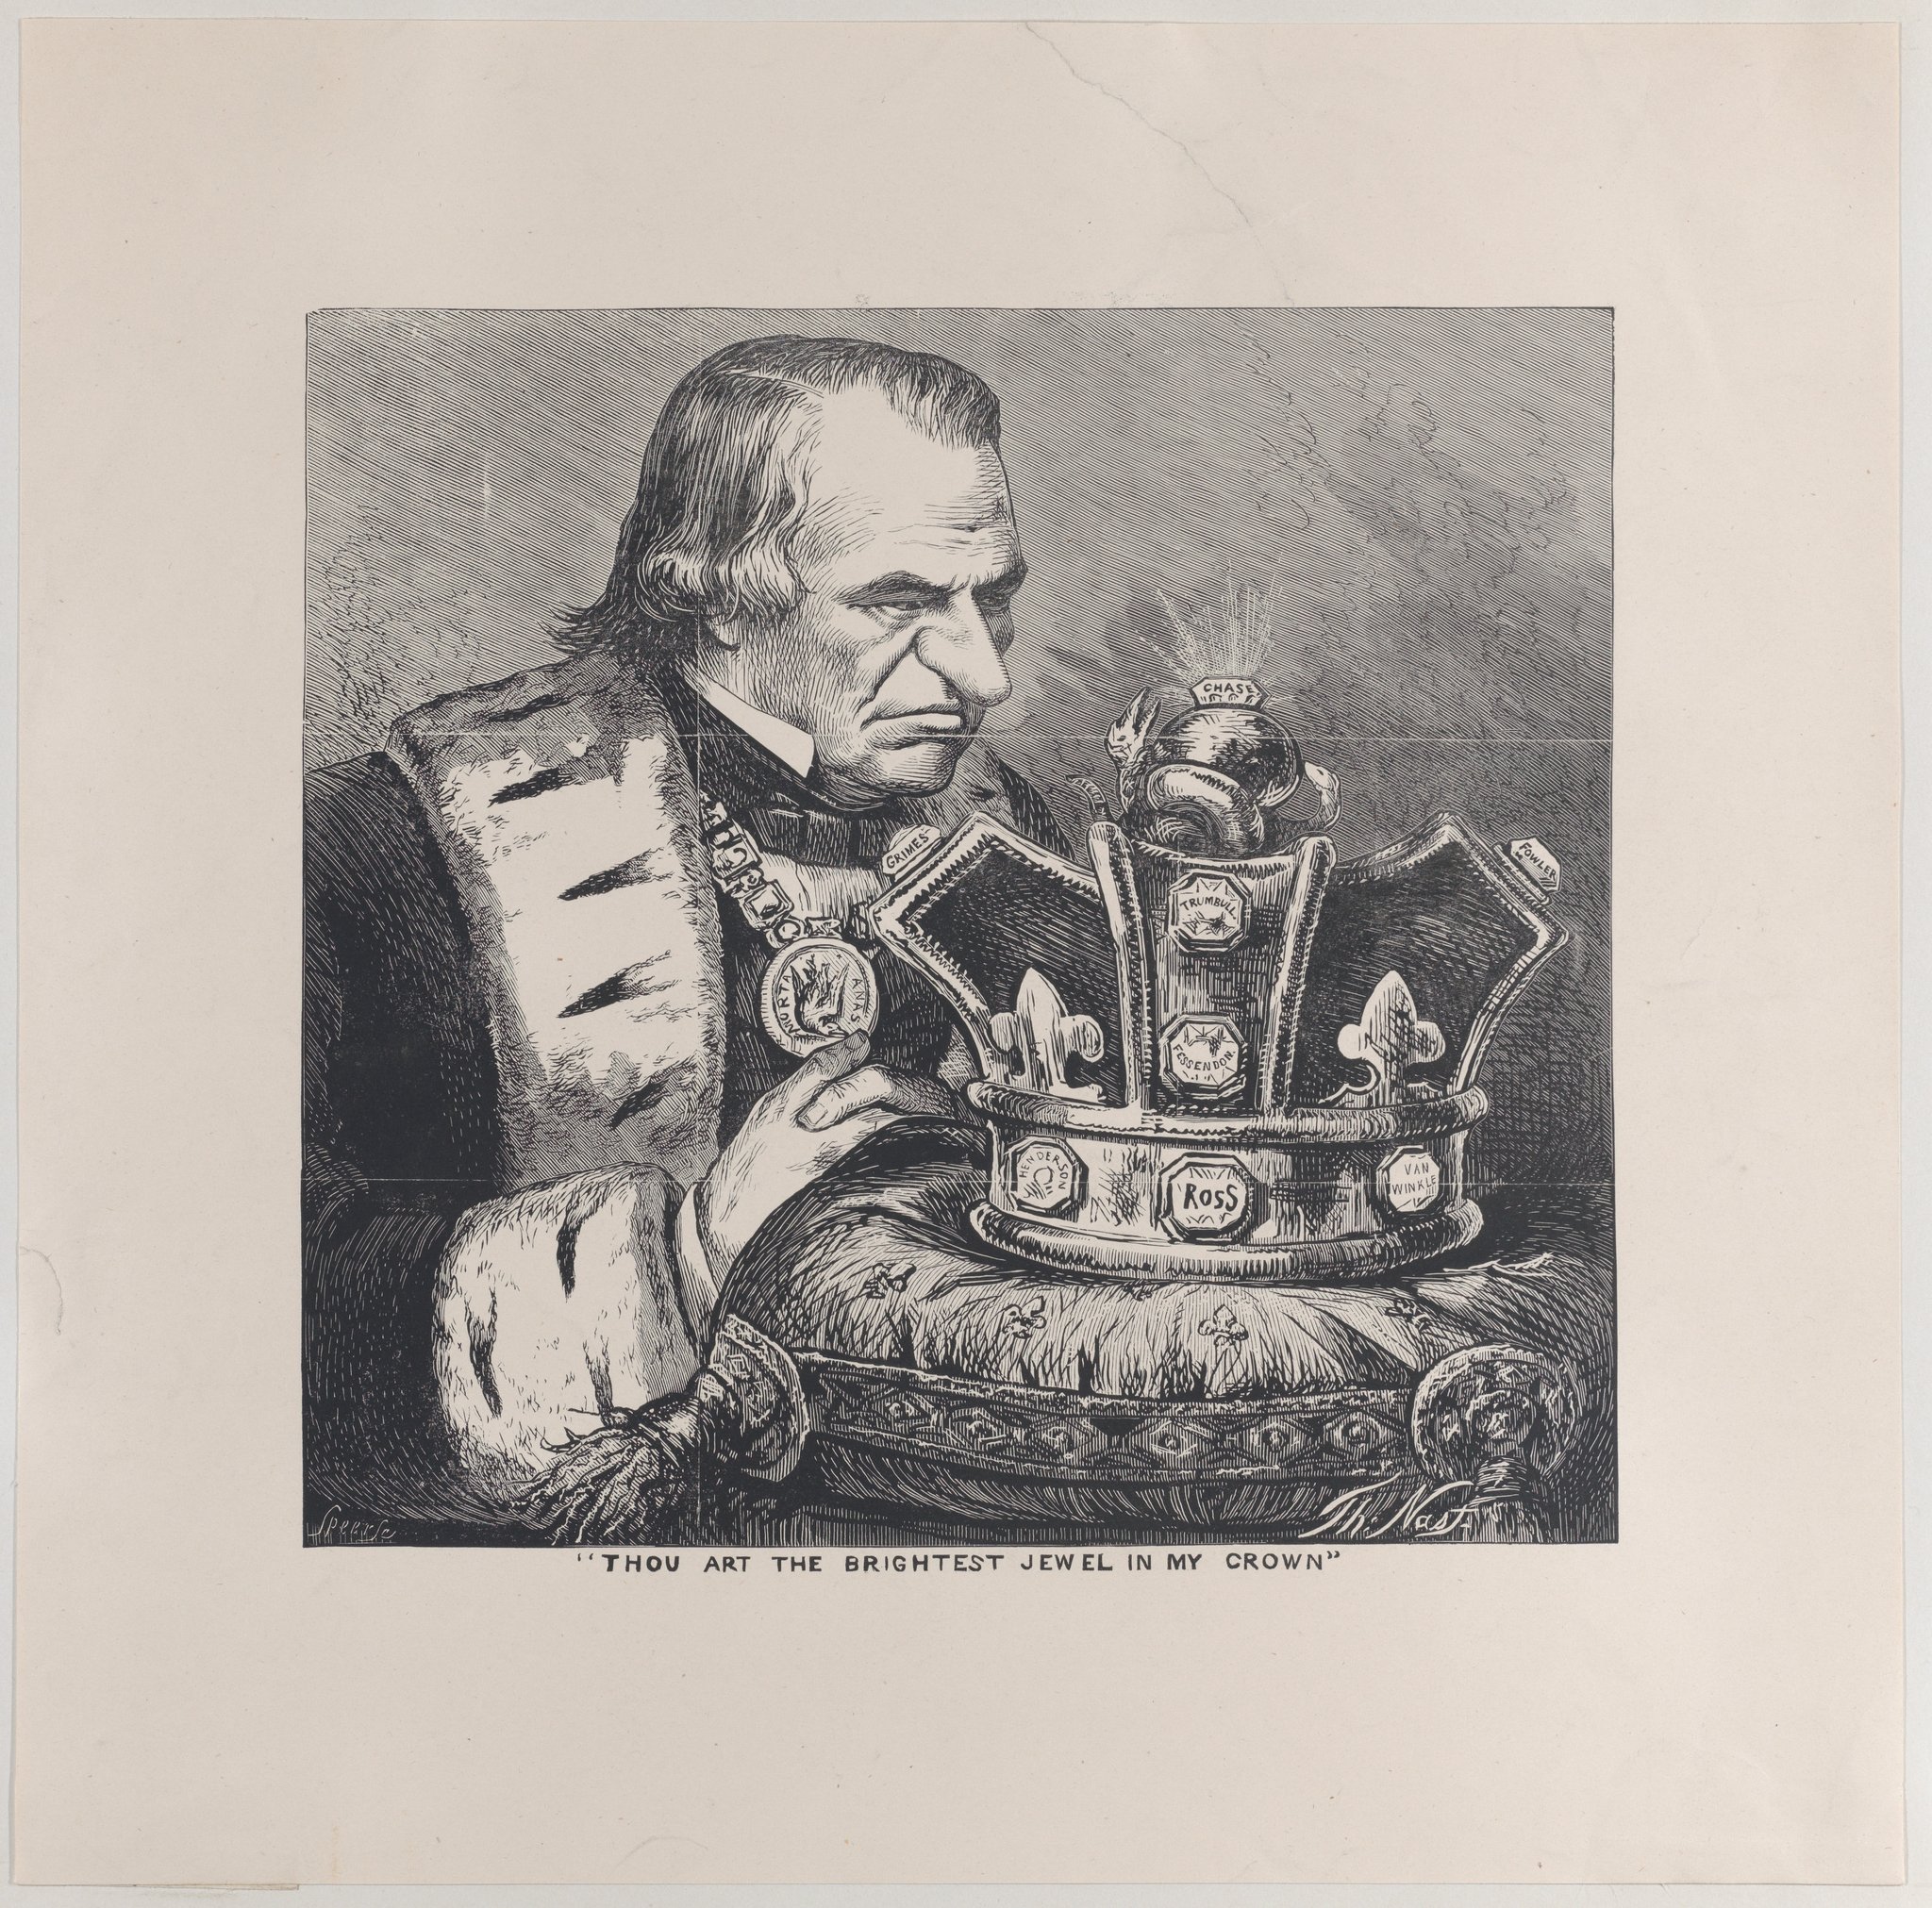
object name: print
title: Thou Art the Brightest Jewel in My Crown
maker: thomas nast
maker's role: artist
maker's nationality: american, born germany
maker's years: 1840-1902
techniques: relief print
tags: satire,men,crowns